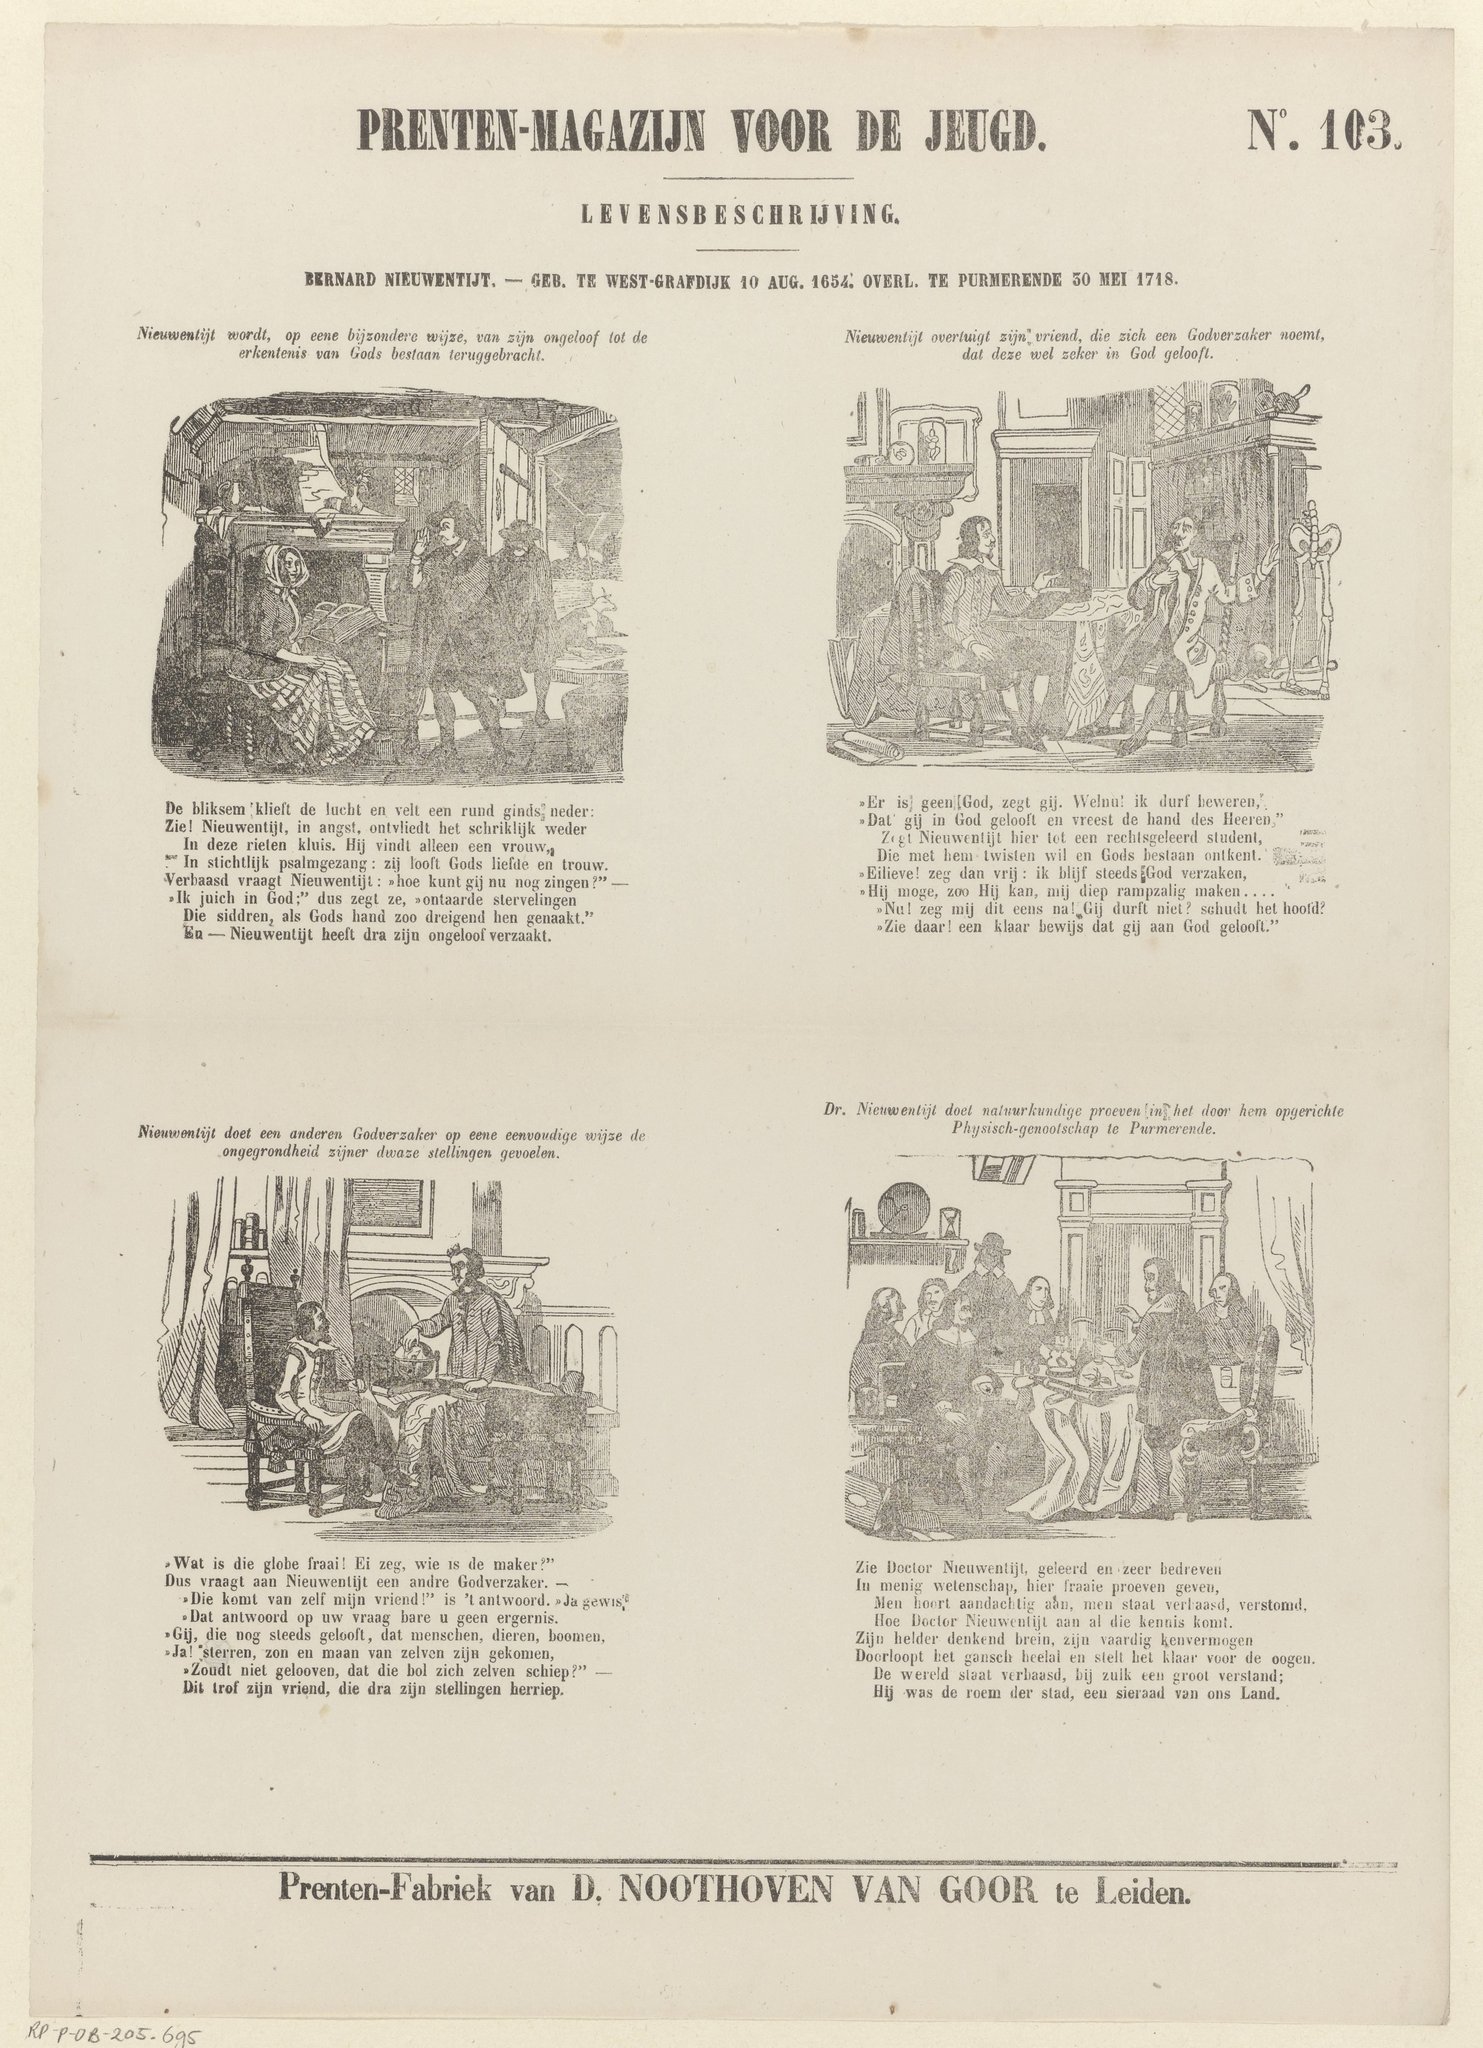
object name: popular print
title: Levensbeschrijving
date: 1850-1881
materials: paper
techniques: letterpress printing, engraving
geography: leiden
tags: west-graftdijk, purmerend, wiskundige, arts, bernard nieuwentijt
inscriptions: collector's mark: Lugt 2760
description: Blad met 4 voorstellingen uit het leven van Bernard Nieuwentijt. Boven elke voorstelling een titel en onder elke voorstelling een achtregelig vers. Genummerd rechtsboven: No. 103.